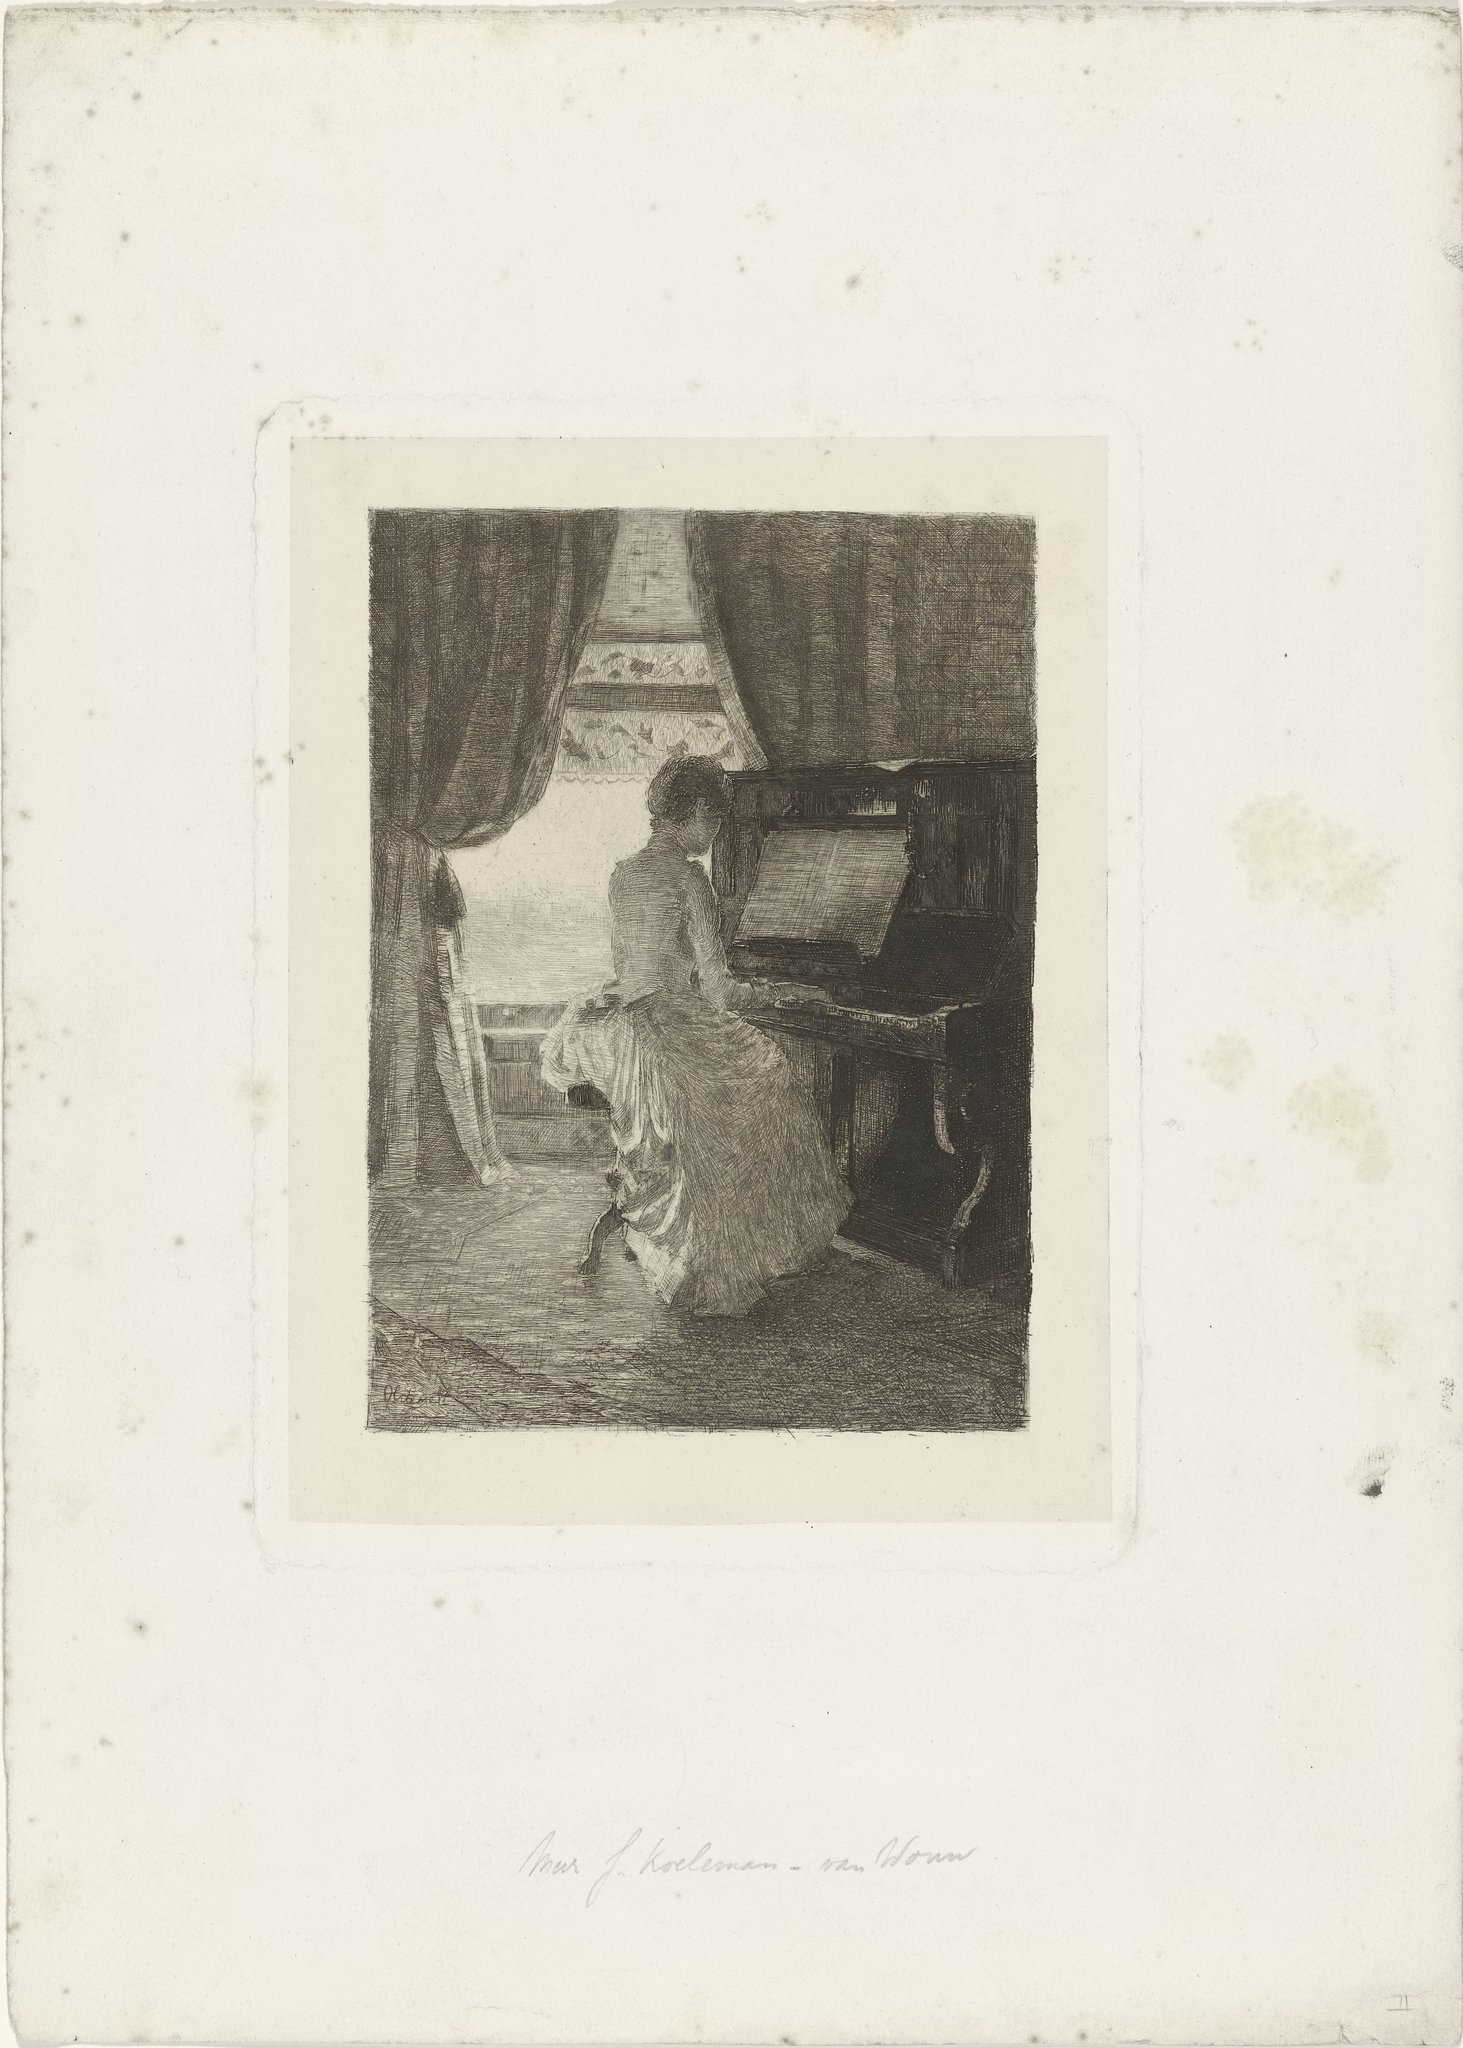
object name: print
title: Jonge vrouw speelt piano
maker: ferdinand oldewelt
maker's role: draughtsman, print maker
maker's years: 1857-1935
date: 1886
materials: paper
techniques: drypoint, etching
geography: netherlands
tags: pianoforte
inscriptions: collector's mark: Lugt 2228, inscription: ‘Mevr. J. Koeleman-Van Wou’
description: Een jonge vrouw (volgens annotatie mevr. Koeleman-Van Wou) speelt piano. Op de achtergrond is door het raam een stadsgezicht herkenbaar.